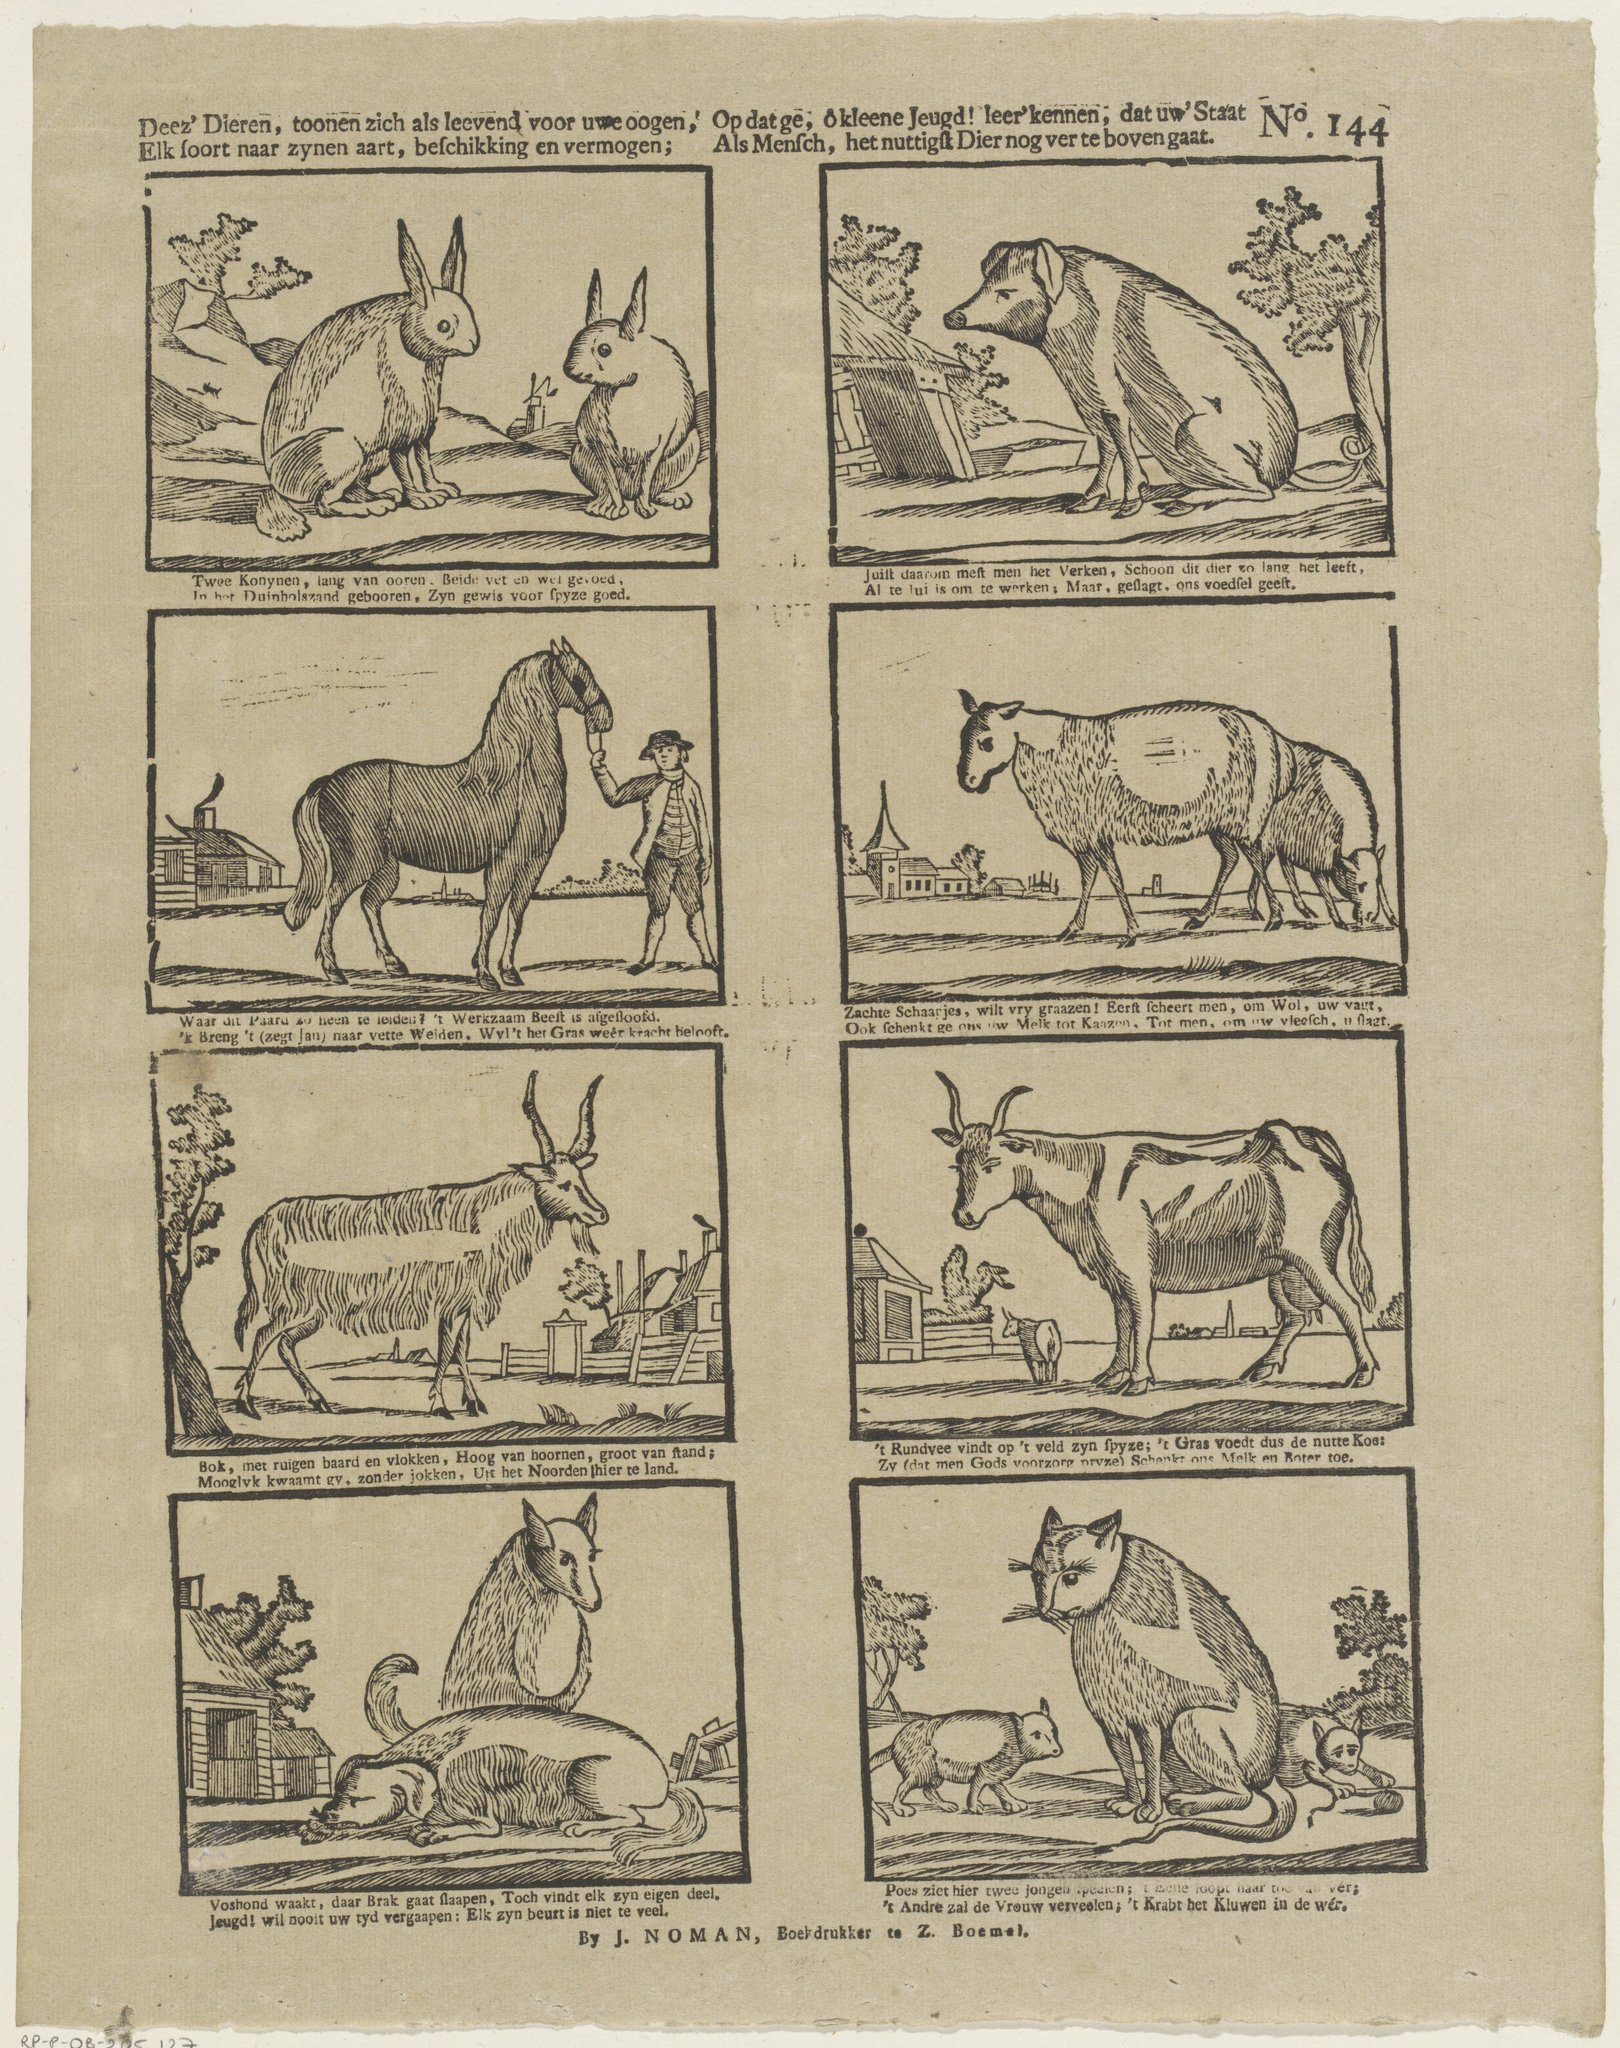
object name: print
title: Deez' dieren, toonen zich als leevend voor uwe oogen, / Elk soort naar zynen aart, beschikking en vermogen; / Op dat ge, ô kleene jeugd! leer' kennen, dat uw' staat / Als mensch, het nuttigst dier nog ver te boven gaat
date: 1806-1830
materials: paper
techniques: letterpress printing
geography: netherlands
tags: cow, animals, cat, horse, rodents: rabbit, dog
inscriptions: collector's mark: Lugt 2760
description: Blad met 8 voorstellingen van dieren, zoals een varken, een paard en een schaap. Onder elke afbeelding een vierregelig vers. Genummerd rechtsboven: No. 144.